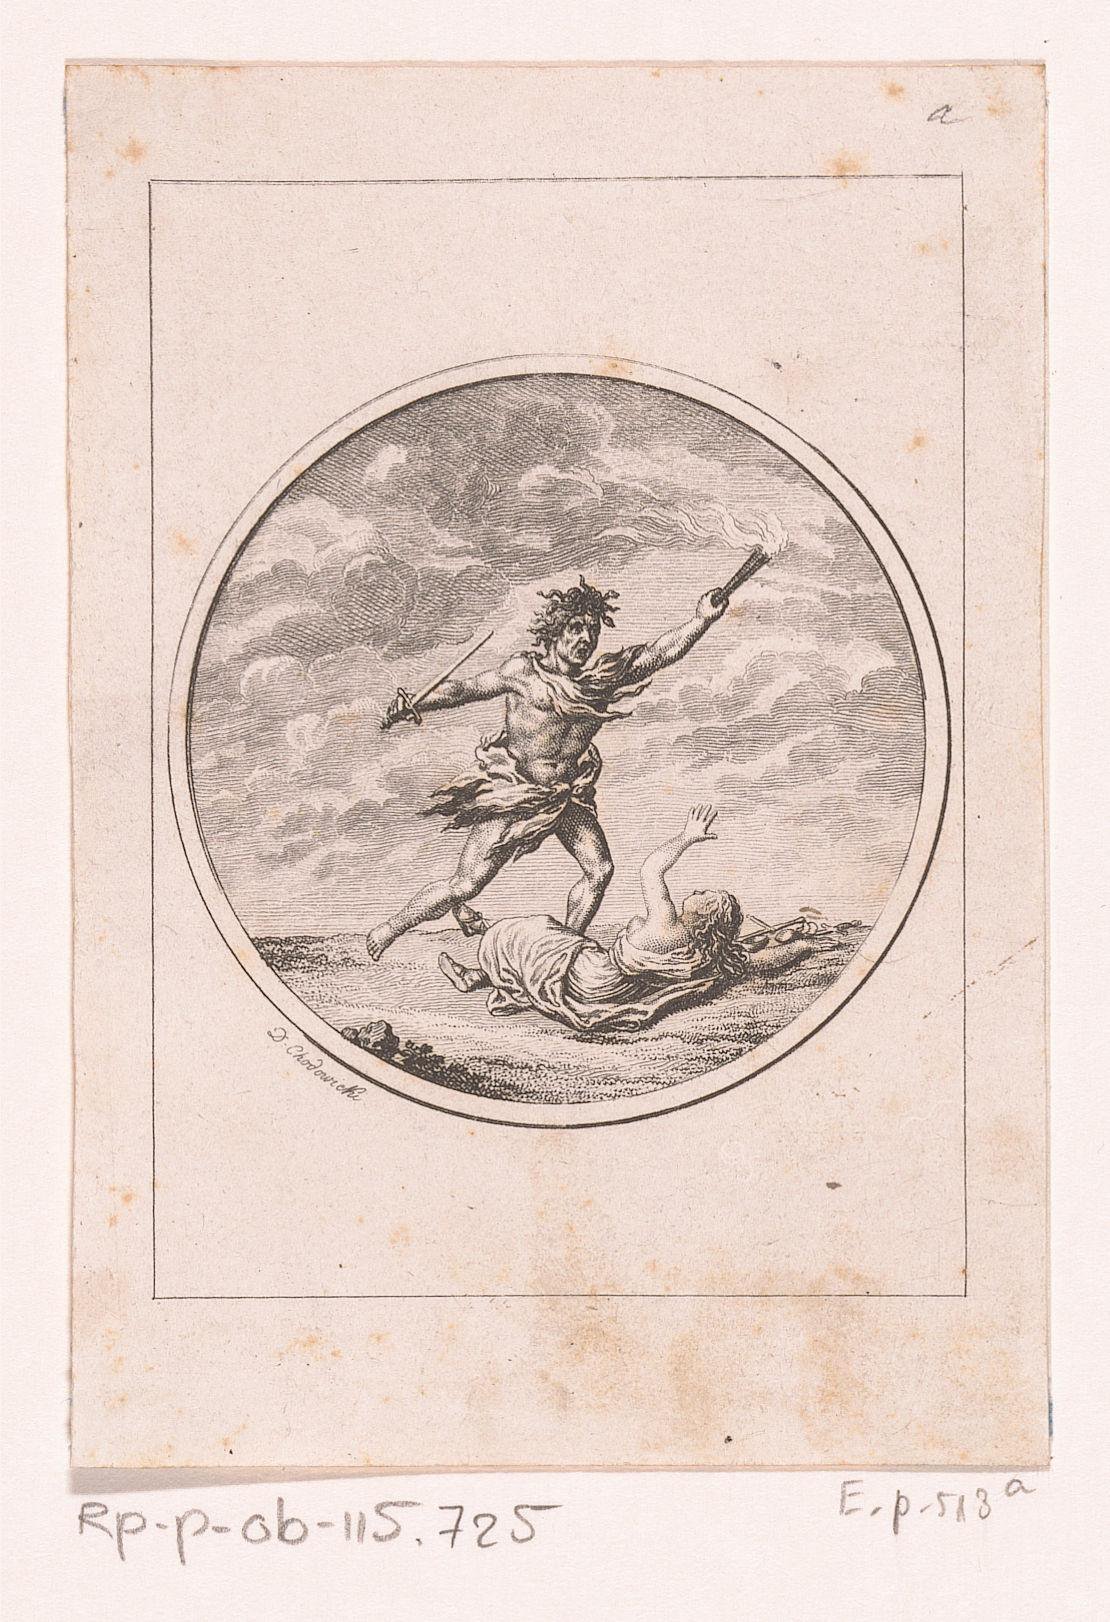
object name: print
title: Furie van de Tweedracht stort zich op Gerechtigheid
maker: daniel nikolaus chodowiecki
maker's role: draughtsman, print maker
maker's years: 1726-1801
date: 1736-1857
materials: paper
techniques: etching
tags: justitia (justice) as roman personification, discordia (discord) as roman personification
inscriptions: collector's mark: Lugt 2228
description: Engelmann trekt de authenticiteit van deze prent in twijfel.